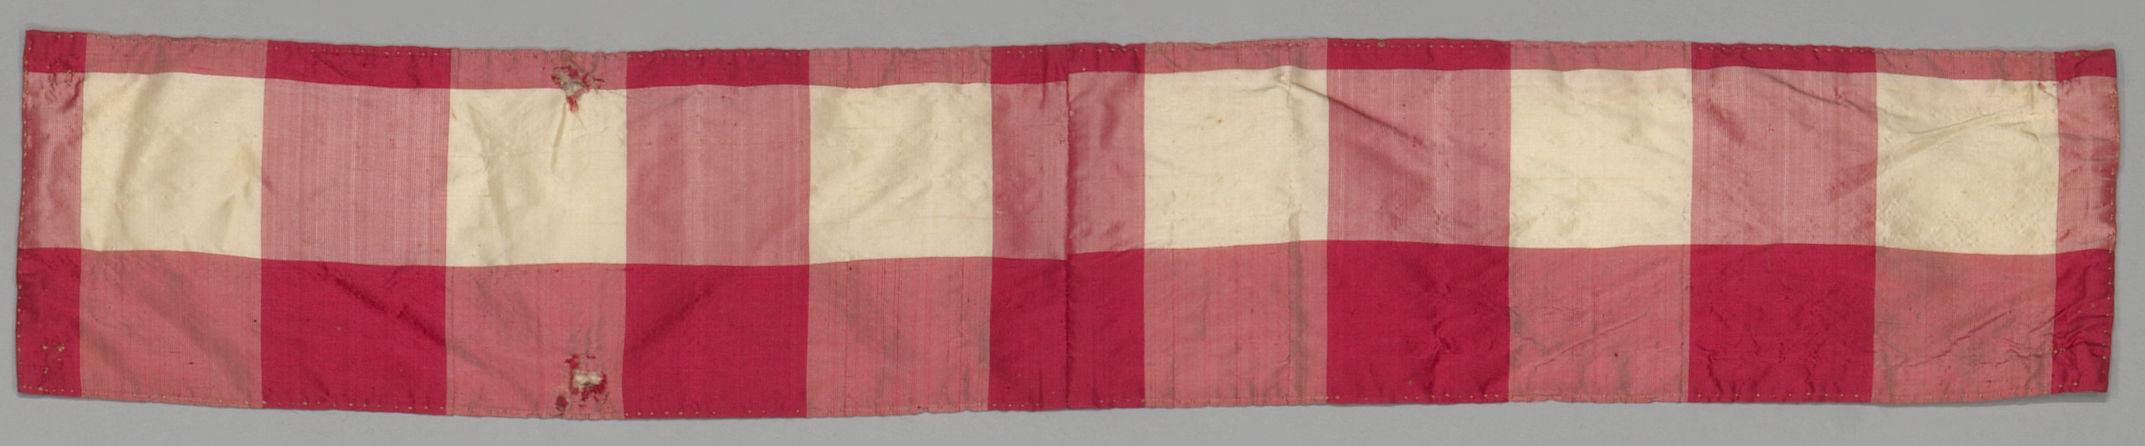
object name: tieback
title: Embrasse van rood-wit geblokte zijde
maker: Anonymous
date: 1776-1800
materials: linen, silk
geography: northern netherlands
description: Embrasse van rood-wit geblokte zijde, gevoerd met wit linnen en met twee stel metalen haken en ogen.